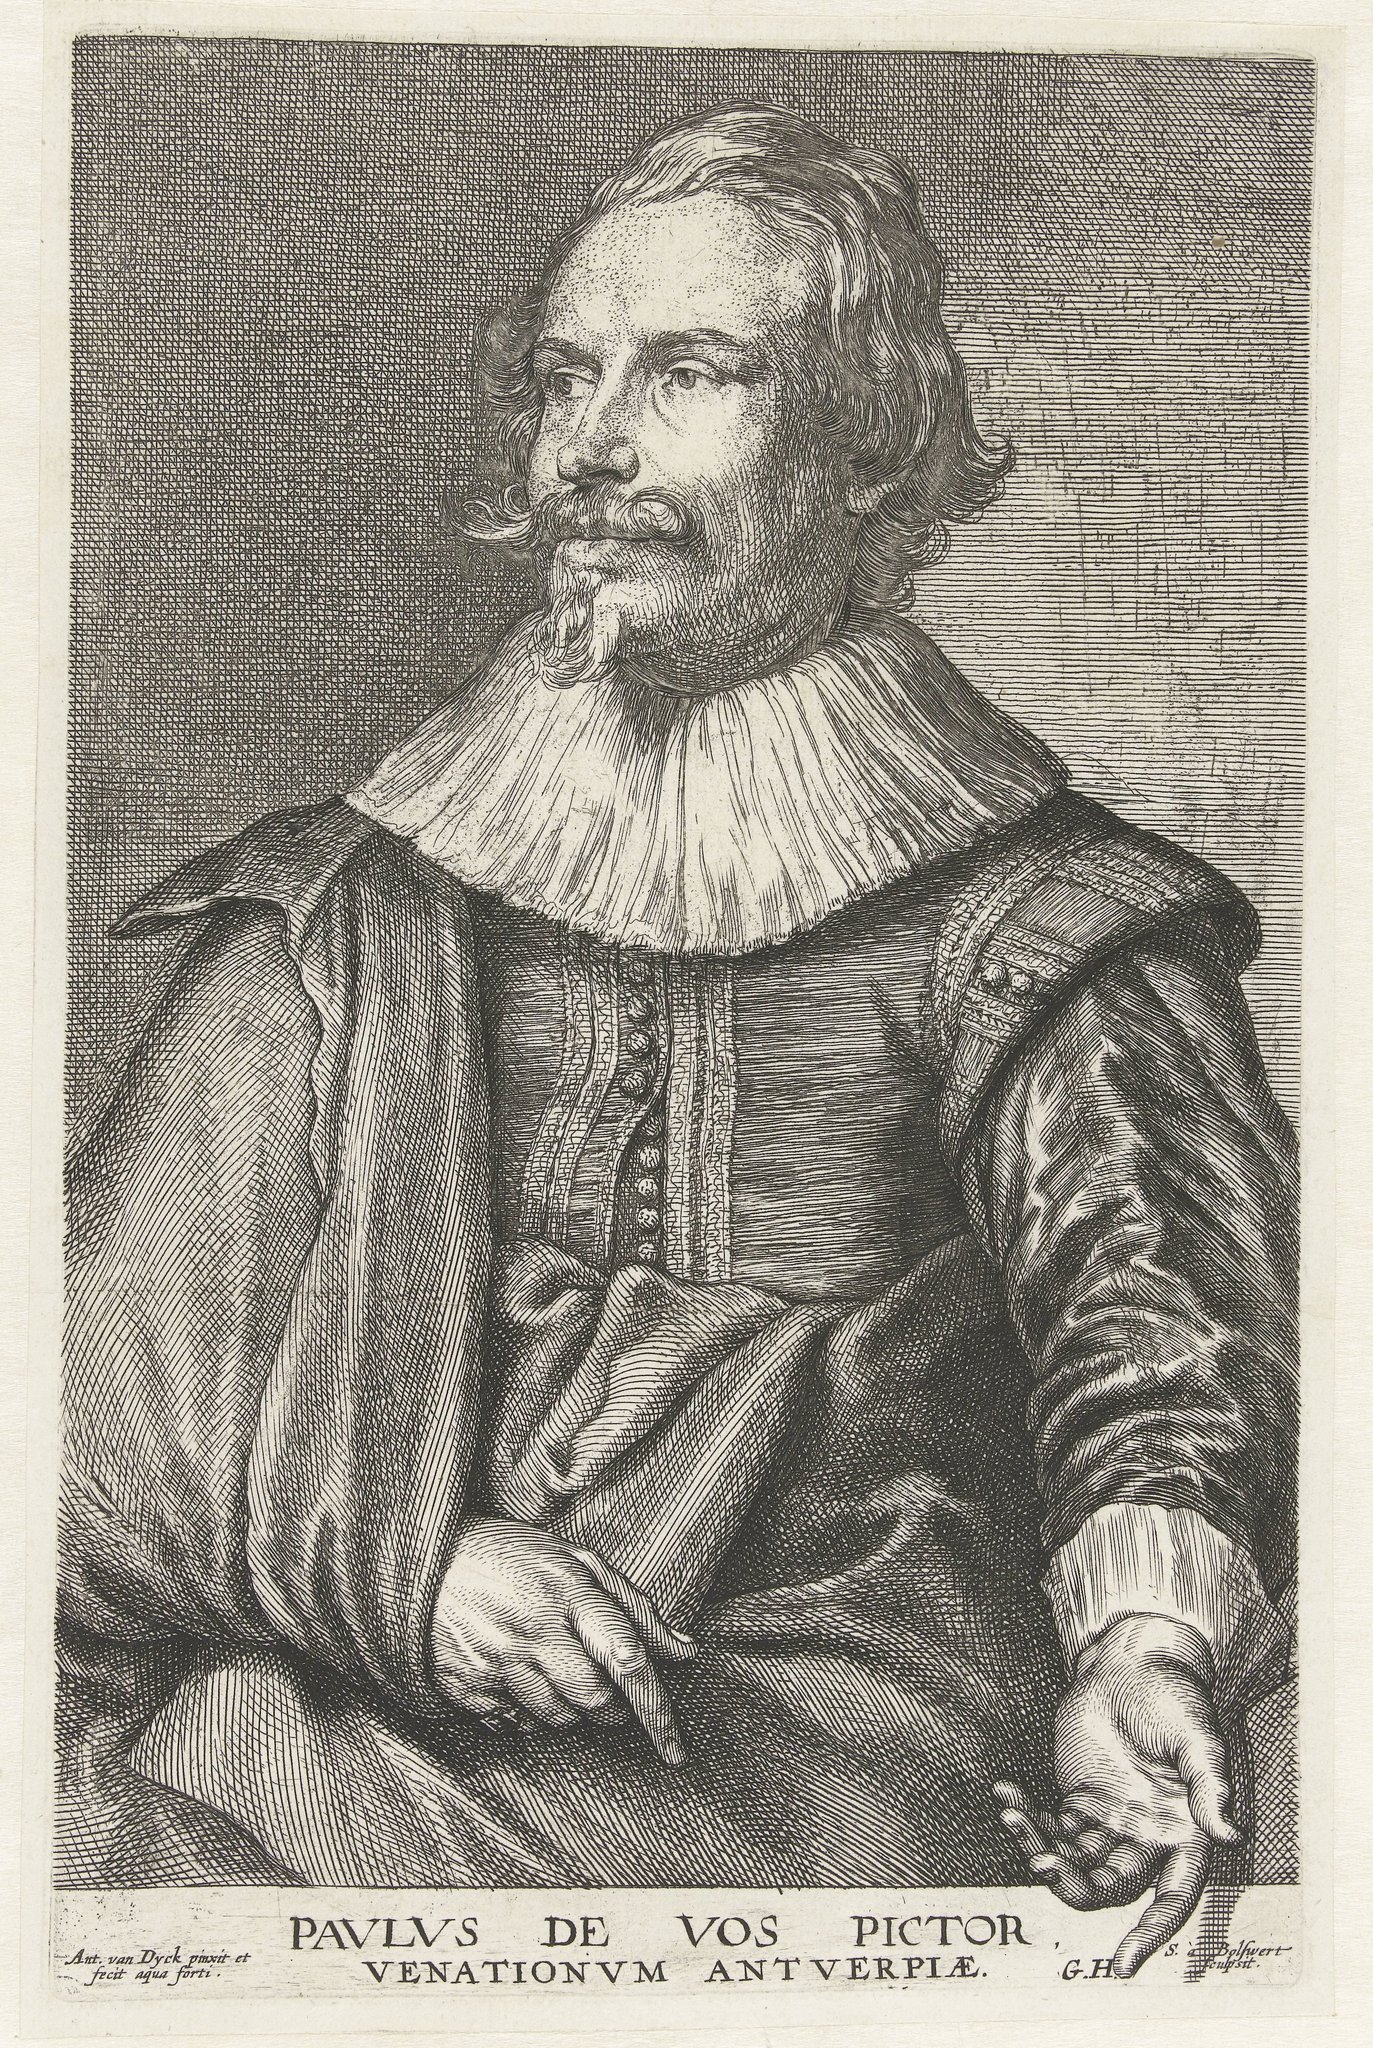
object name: print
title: Portret van Paul de Vos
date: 1630-1641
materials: paper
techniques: engraving, etching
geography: low countries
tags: antwerp, draughtsman, paul de vos, portrait, self-portrait of painter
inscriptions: collector's mark: Lugt 240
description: Portret van Paul de Vos met onderschrift PAVLVS DE VOS PICTOR VENATIONVM ANTVERPIAE